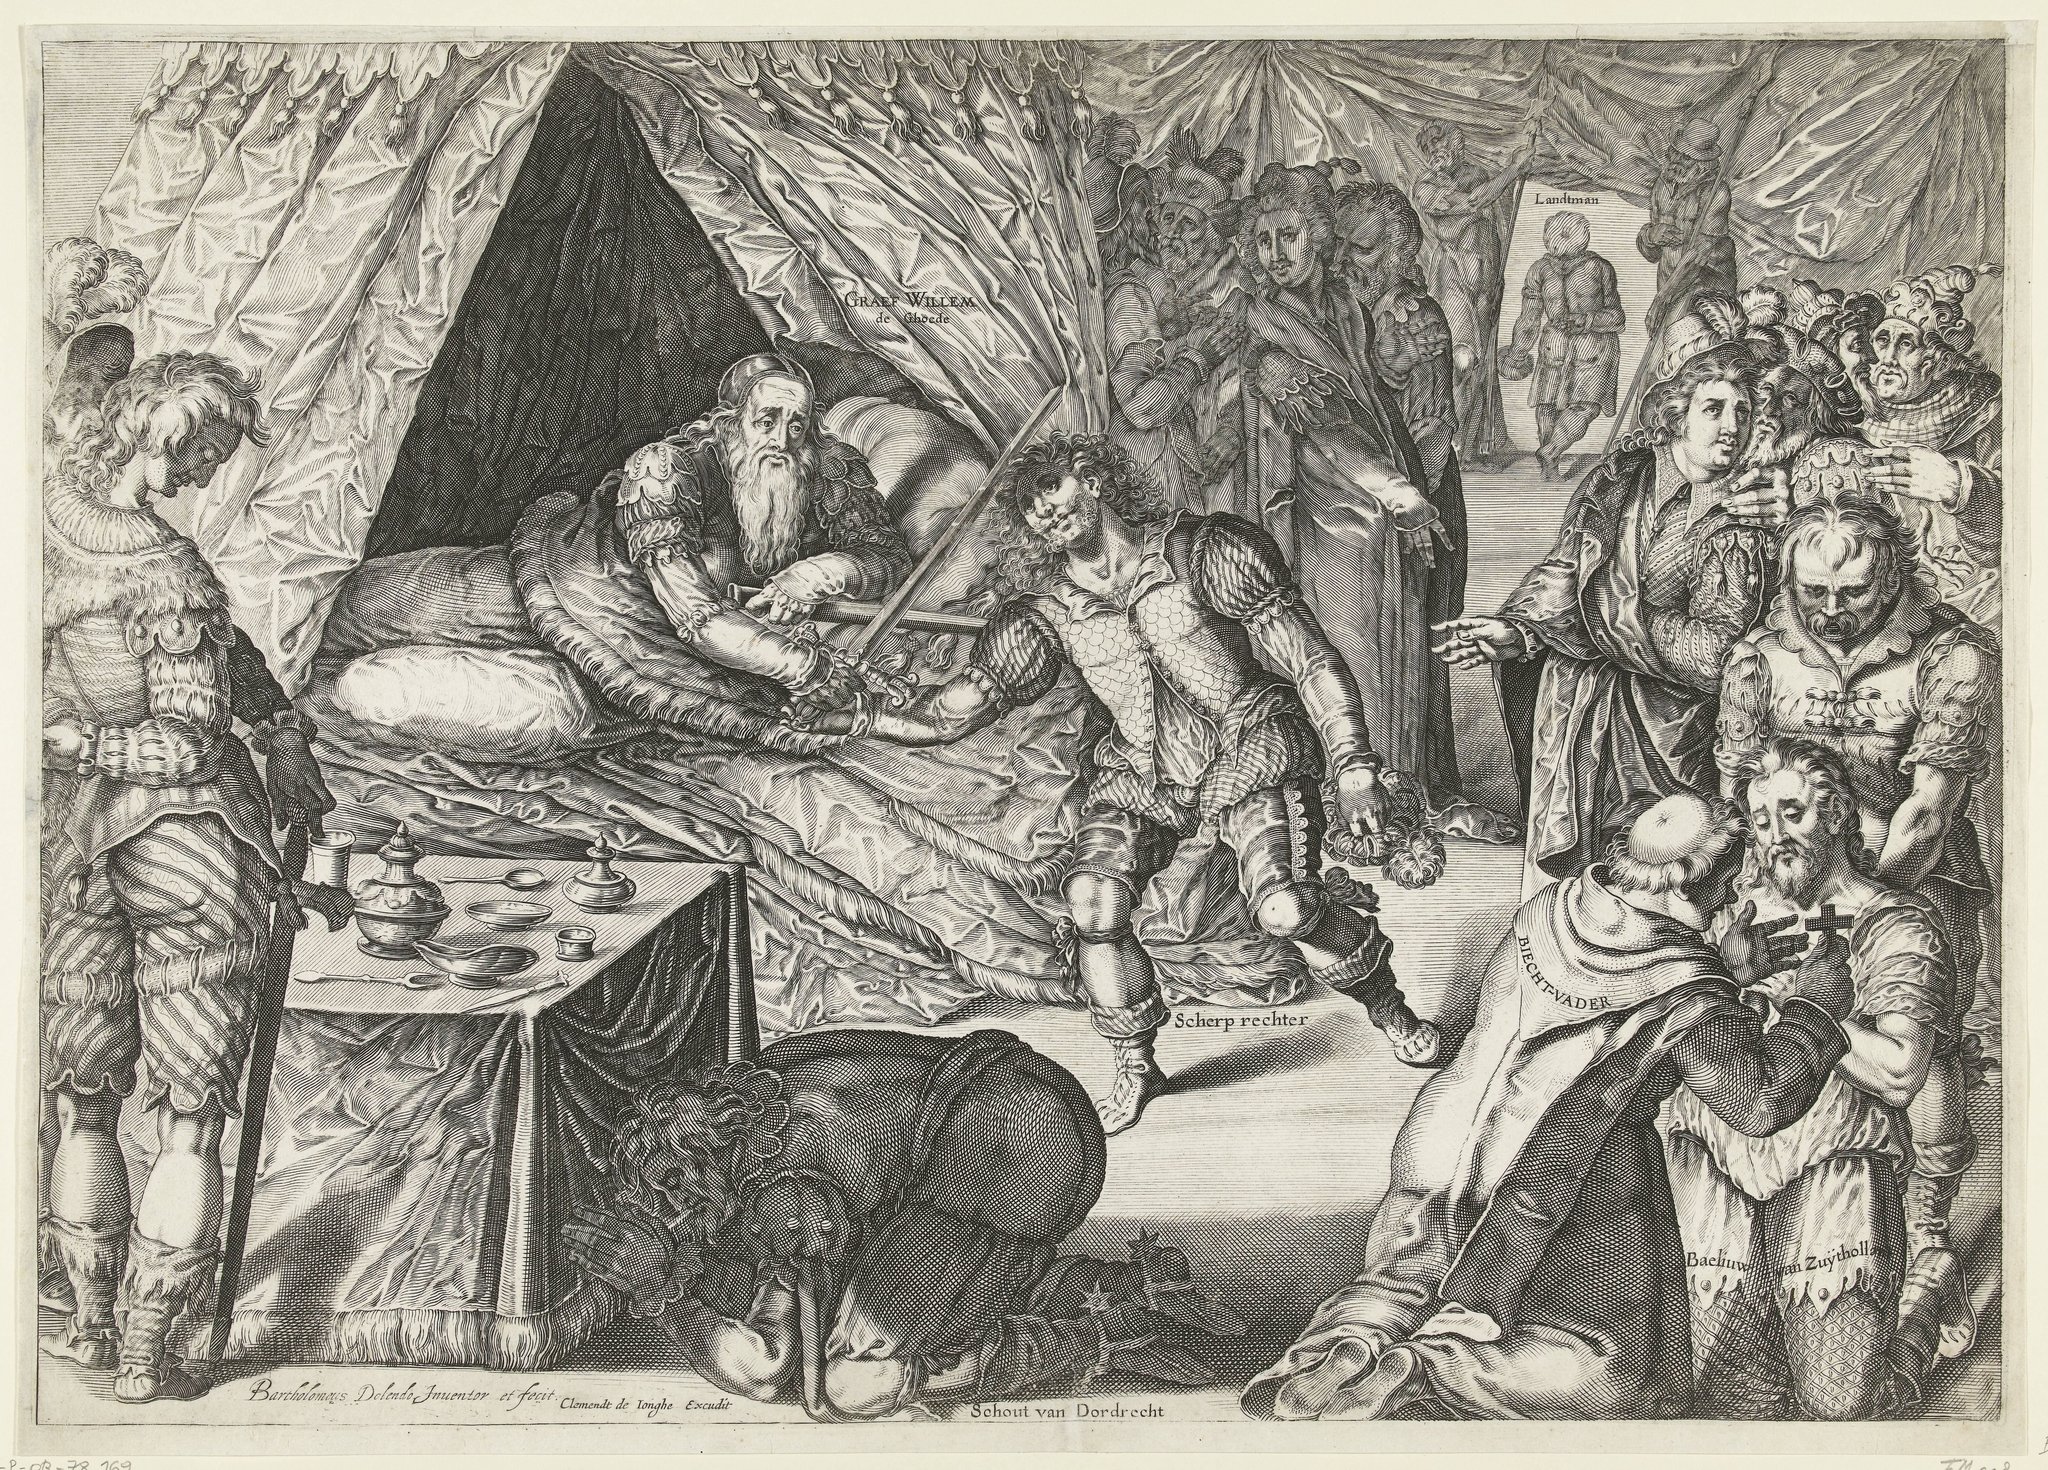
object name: history print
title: Oordeel van graaf Willem III over de baljuw van Zuid-Holland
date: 1613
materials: paper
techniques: engraving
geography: northern netherlands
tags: willem iii de goede (graaf van holland en henegouwen), netherlands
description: Graaf Willem III overhandigt vanuit zijn ziekbed zijn zwaard aan de beul. Op de voorgrond knielt de schout van Dordrecht, rechts wordt de baljuw in voorbereiding op zijn executie door een priester de biecht afgenomen. Centrale voorstelling waaromheen met zes kleine scènes geplaatst kunnen worden van de opeenvolgende episoden van het verhaal van de Rechtspraak van graaf Willem III in het jaar 1336.